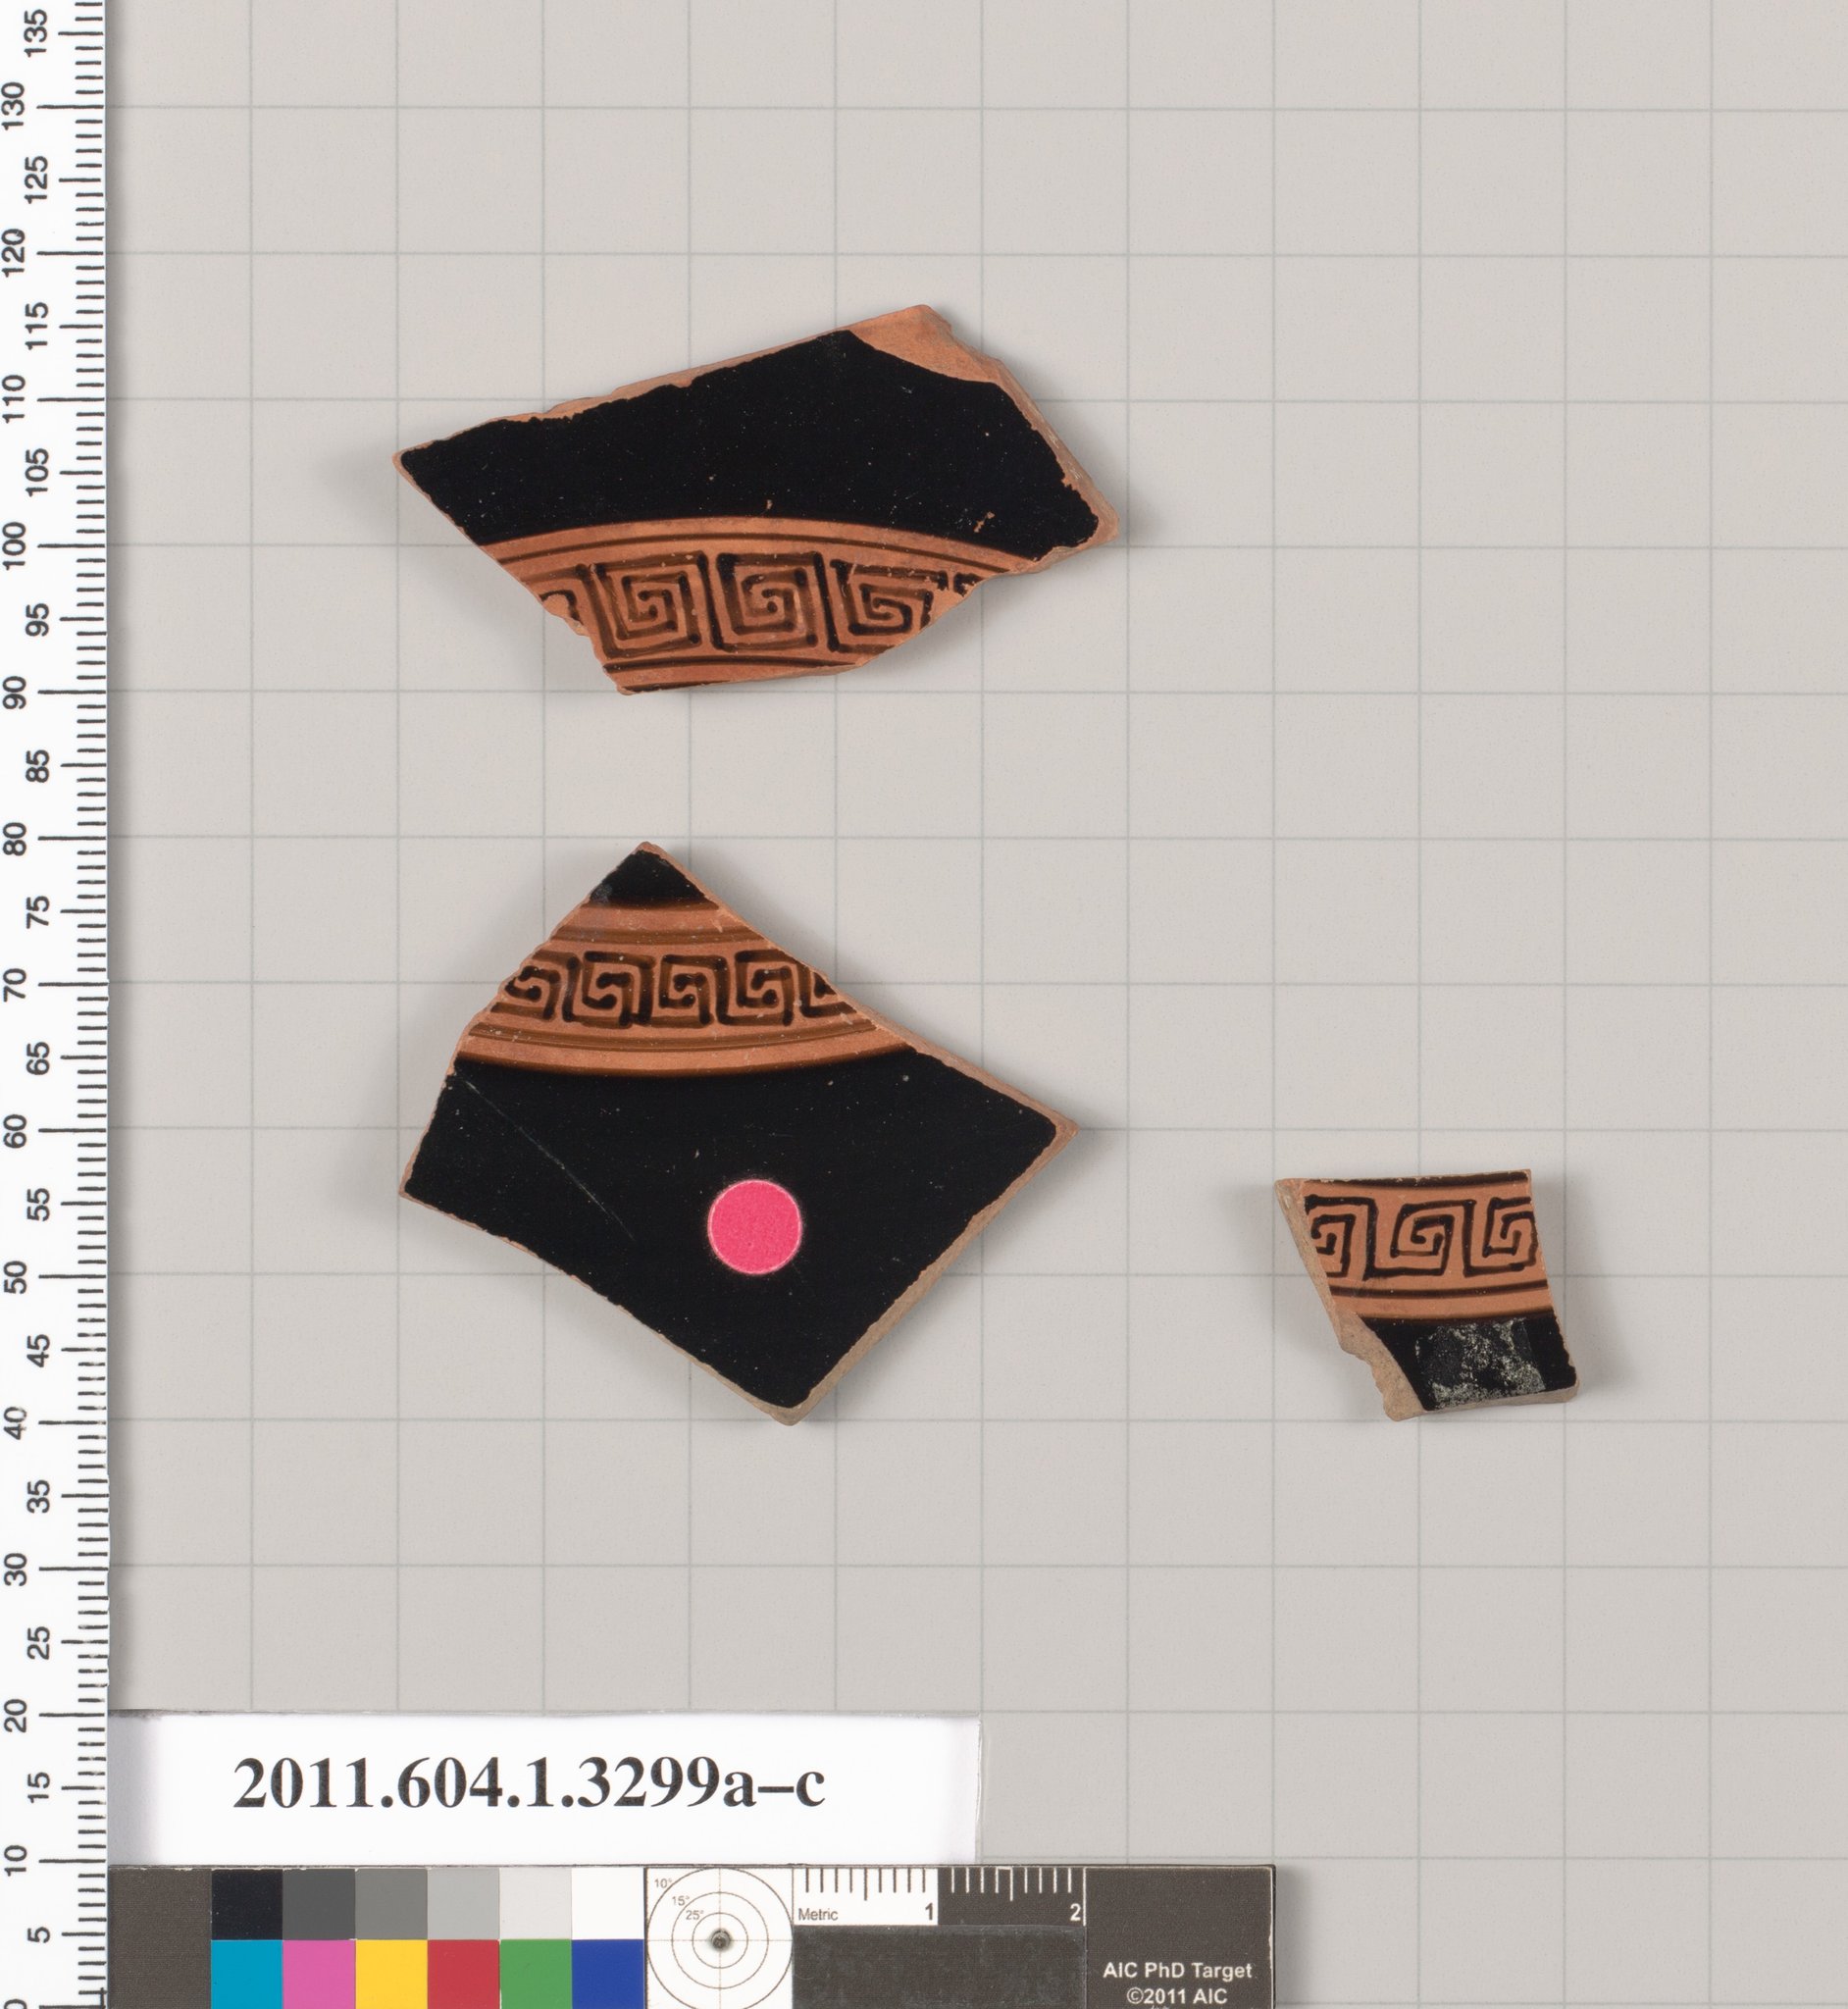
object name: kylix fragment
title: Terracotta fragments of kylikes (drinking cups)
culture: greek, attic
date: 500-480 BCE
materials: terracotta